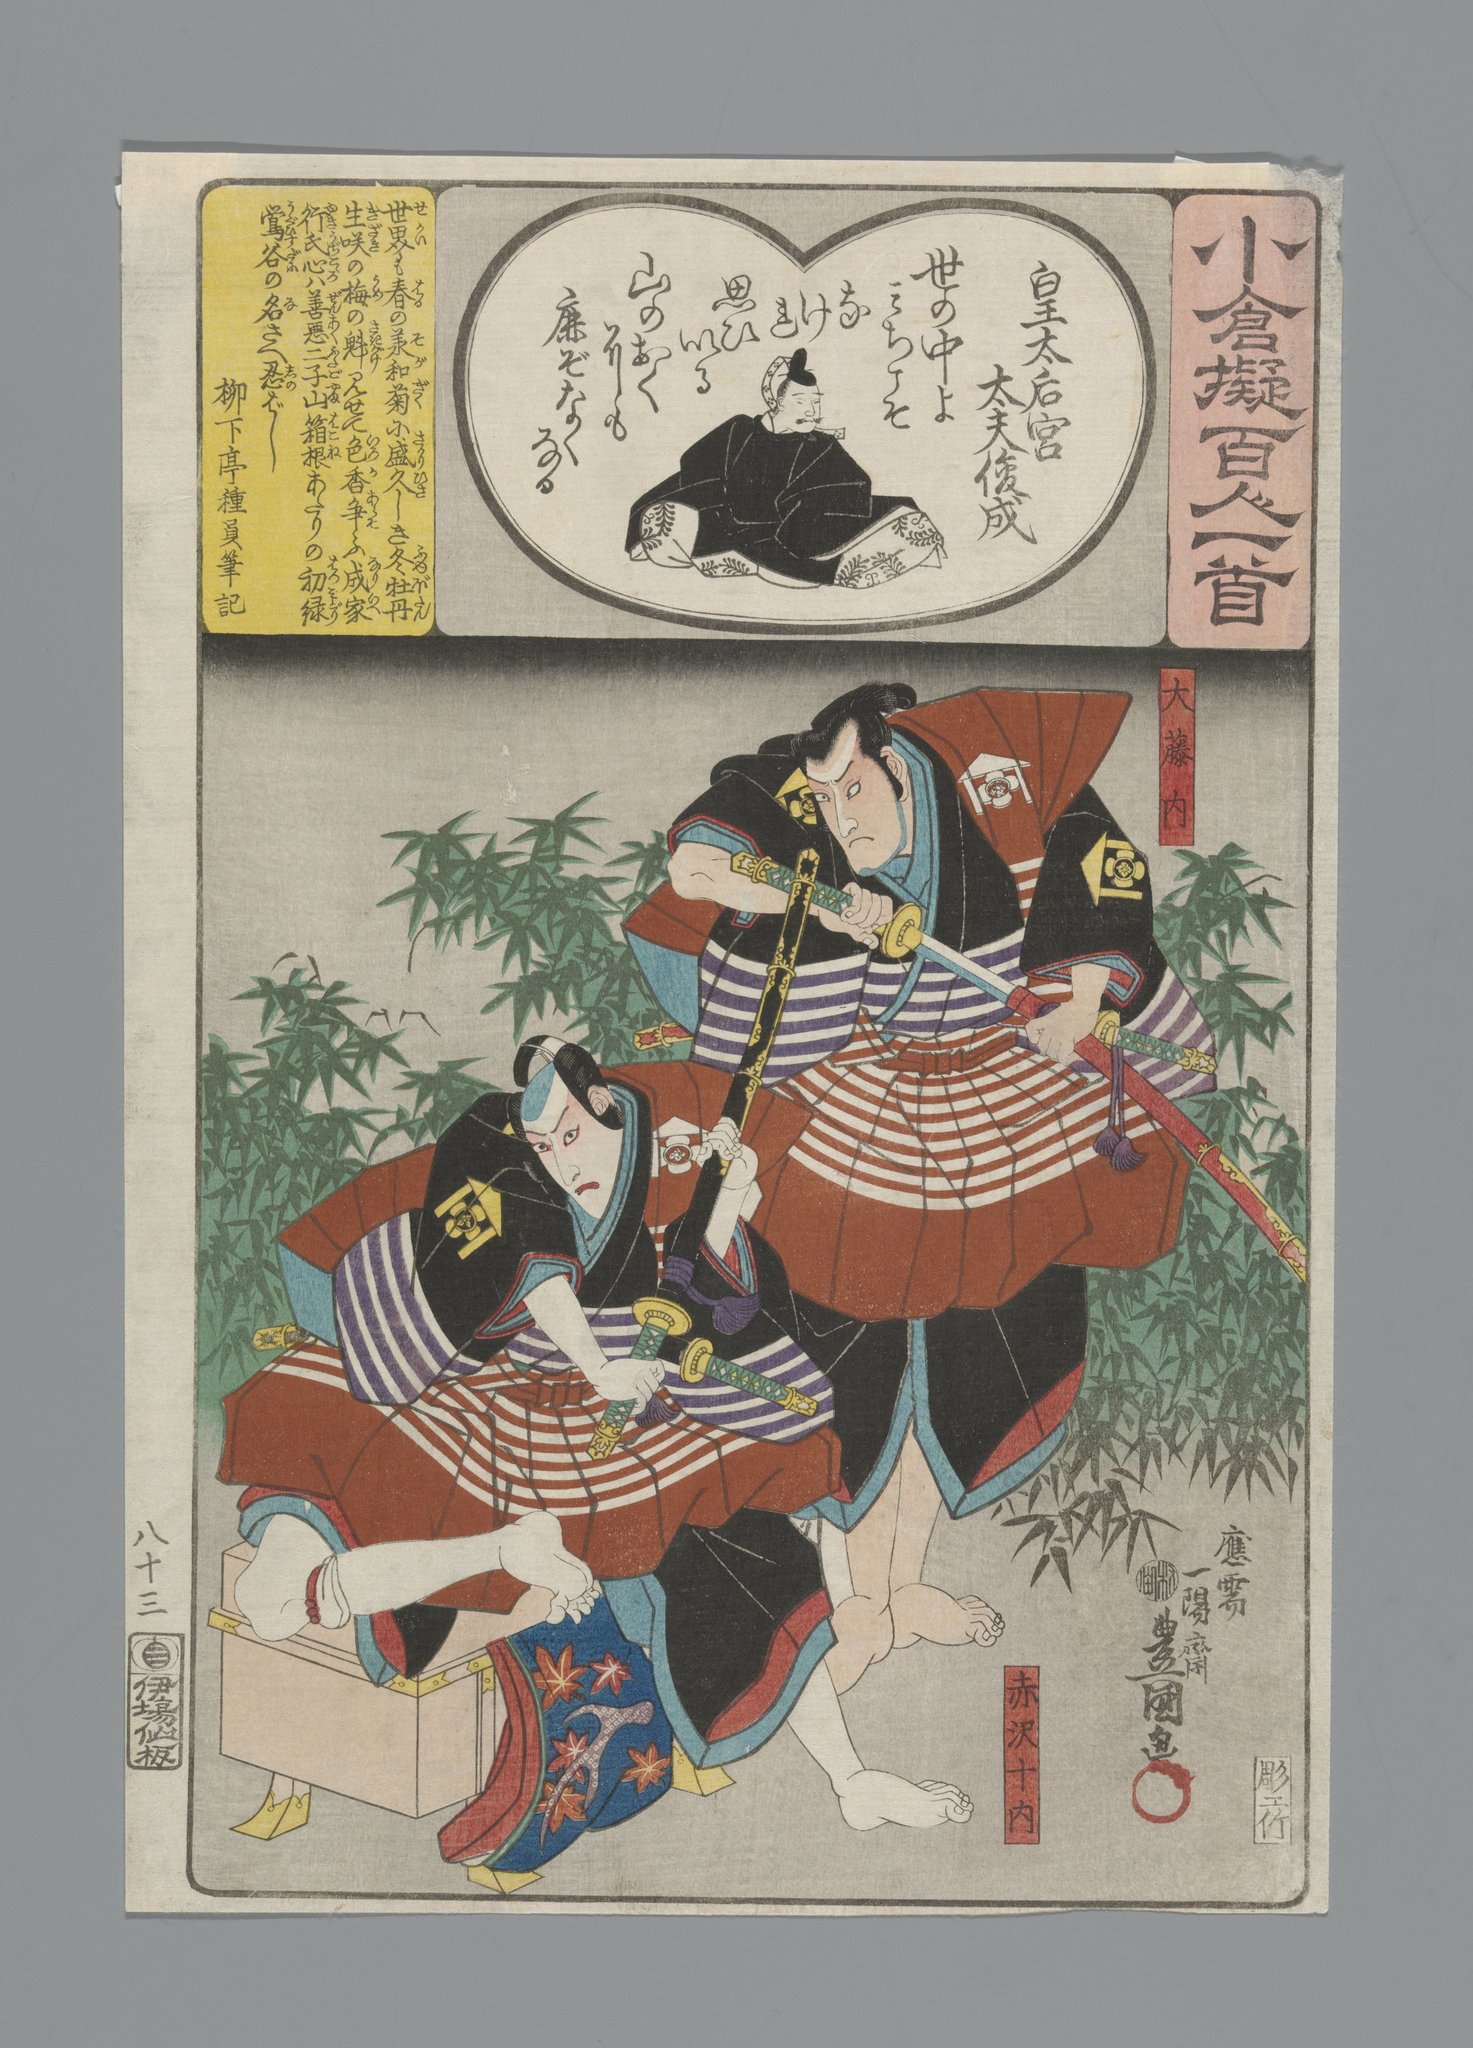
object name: print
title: Ogura Imitation of the One Hundred Poems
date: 1846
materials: paper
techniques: woodcut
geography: japan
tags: adult man (+ two persons), hacking and thrusting weapons: sword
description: Ôtônai trekt zijn zwaard terwijl Akazawa Jûnai op een kist zit. Scene uit een kabukitoneelstuk. Gedicht door Shunzei.